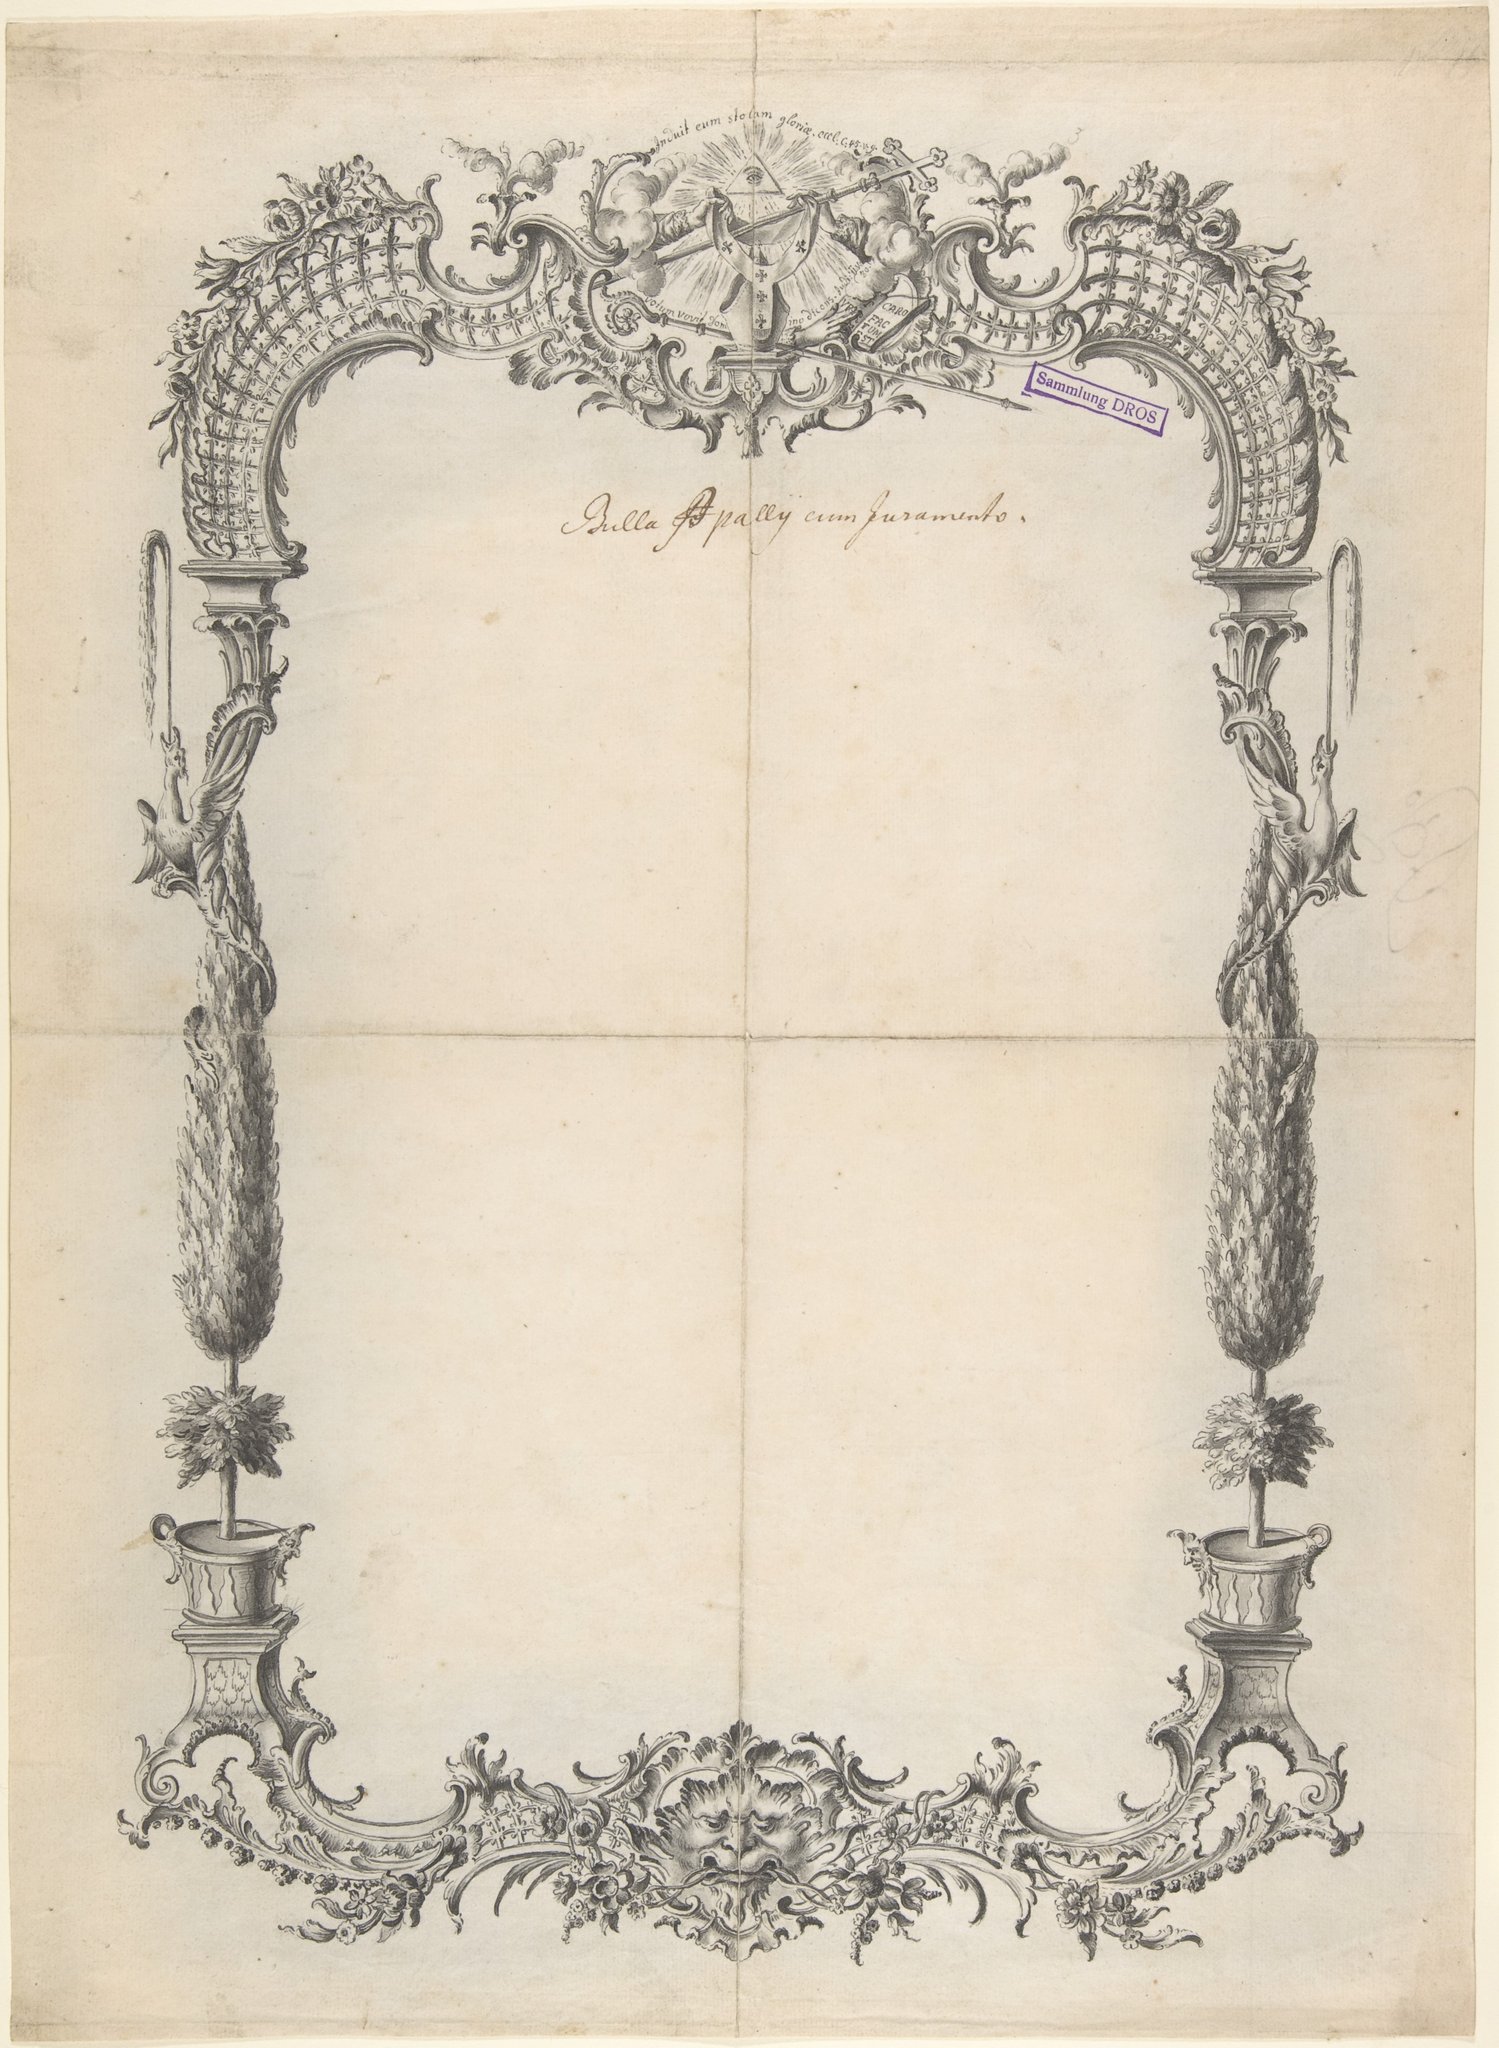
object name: drawing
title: Design for Frame with Trees and Trellises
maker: johann oktavian salver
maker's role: artist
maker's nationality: german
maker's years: 1732-1788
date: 1755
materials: chalk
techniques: brush, incising, transfer, wash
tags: birds,ornament